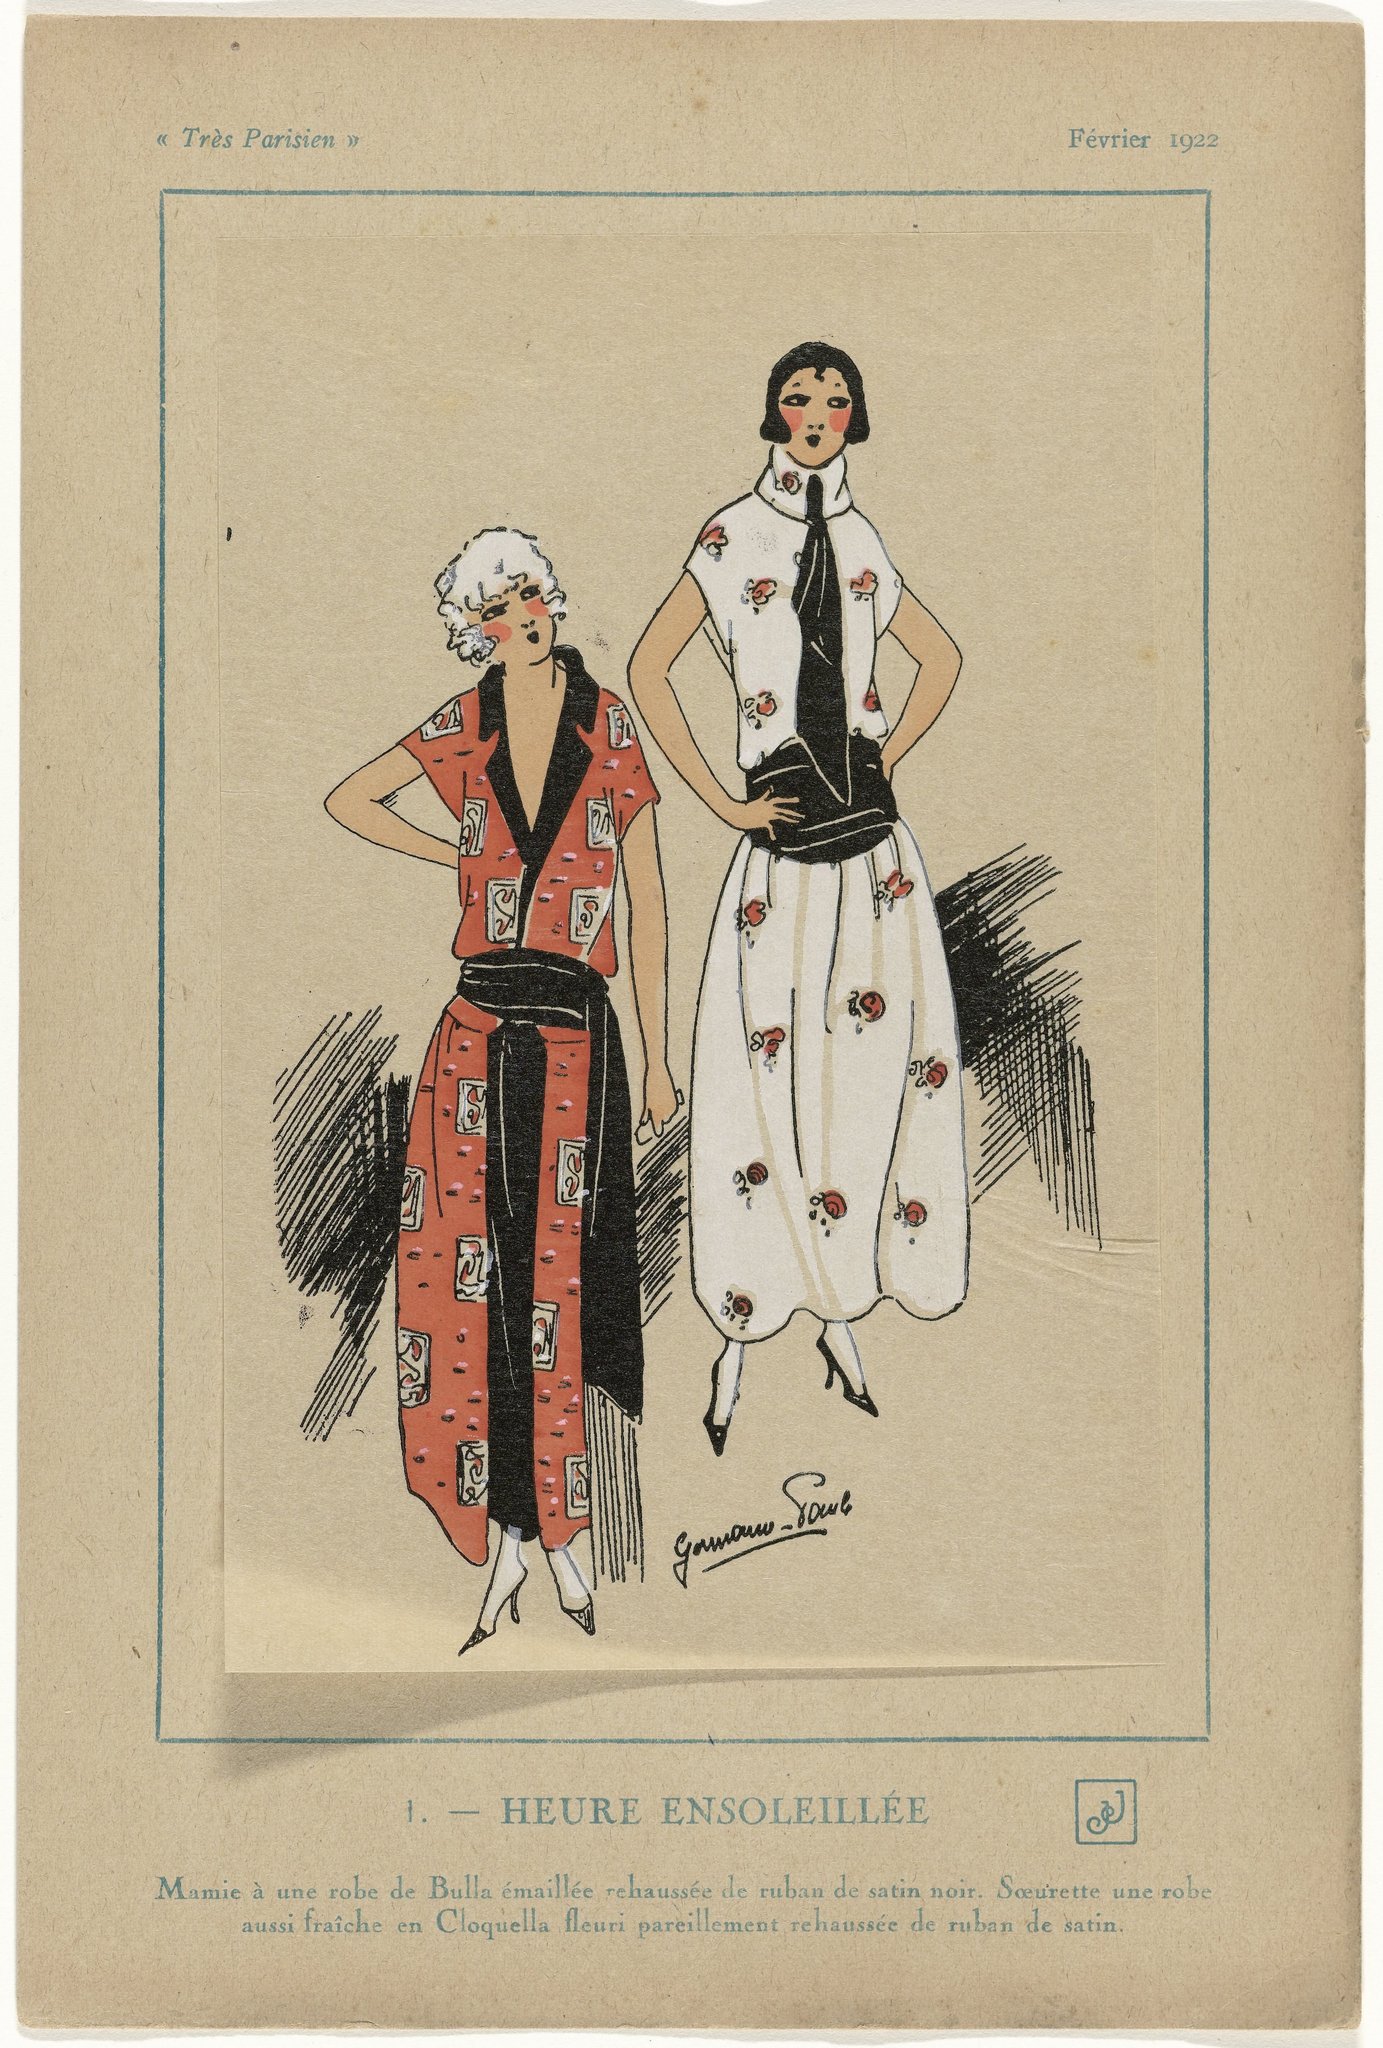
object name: fashion print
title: Très Parisien, 1922: 1.- HEURE ENSOLEILLÉ (...)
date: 1922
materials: paper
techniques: hand coloring, letterpress printing, lithography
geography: paris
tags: neck-gear ~ clothing (revers) (+ women's clothes), border, ribbon, braid (+ women's clothes), fashion plates, dress, gown (+ women's clothes)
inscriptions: caption: ‘1. - HEURE ENSOLEILLÉE / Mamie à une robe de Bulla émaillé rehaussée de ruban satin noir. Soeurette une robe aussi fraîche en Cloquella fleuri pareillement rehaussée de ruban de satin’, title: ‘Très Parisien / Février 1922’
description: Links een rode japon, afgezet met zwart satijn. Witte japon met rode bloemetjes, stropdas en ceintuur van zwart satijn. Gesigneerd 'Germaine-Paule' (= Germaine-Paule Joumard) Prent no. 1 uit het modetijdschrift Très Parisien, februari 1922.